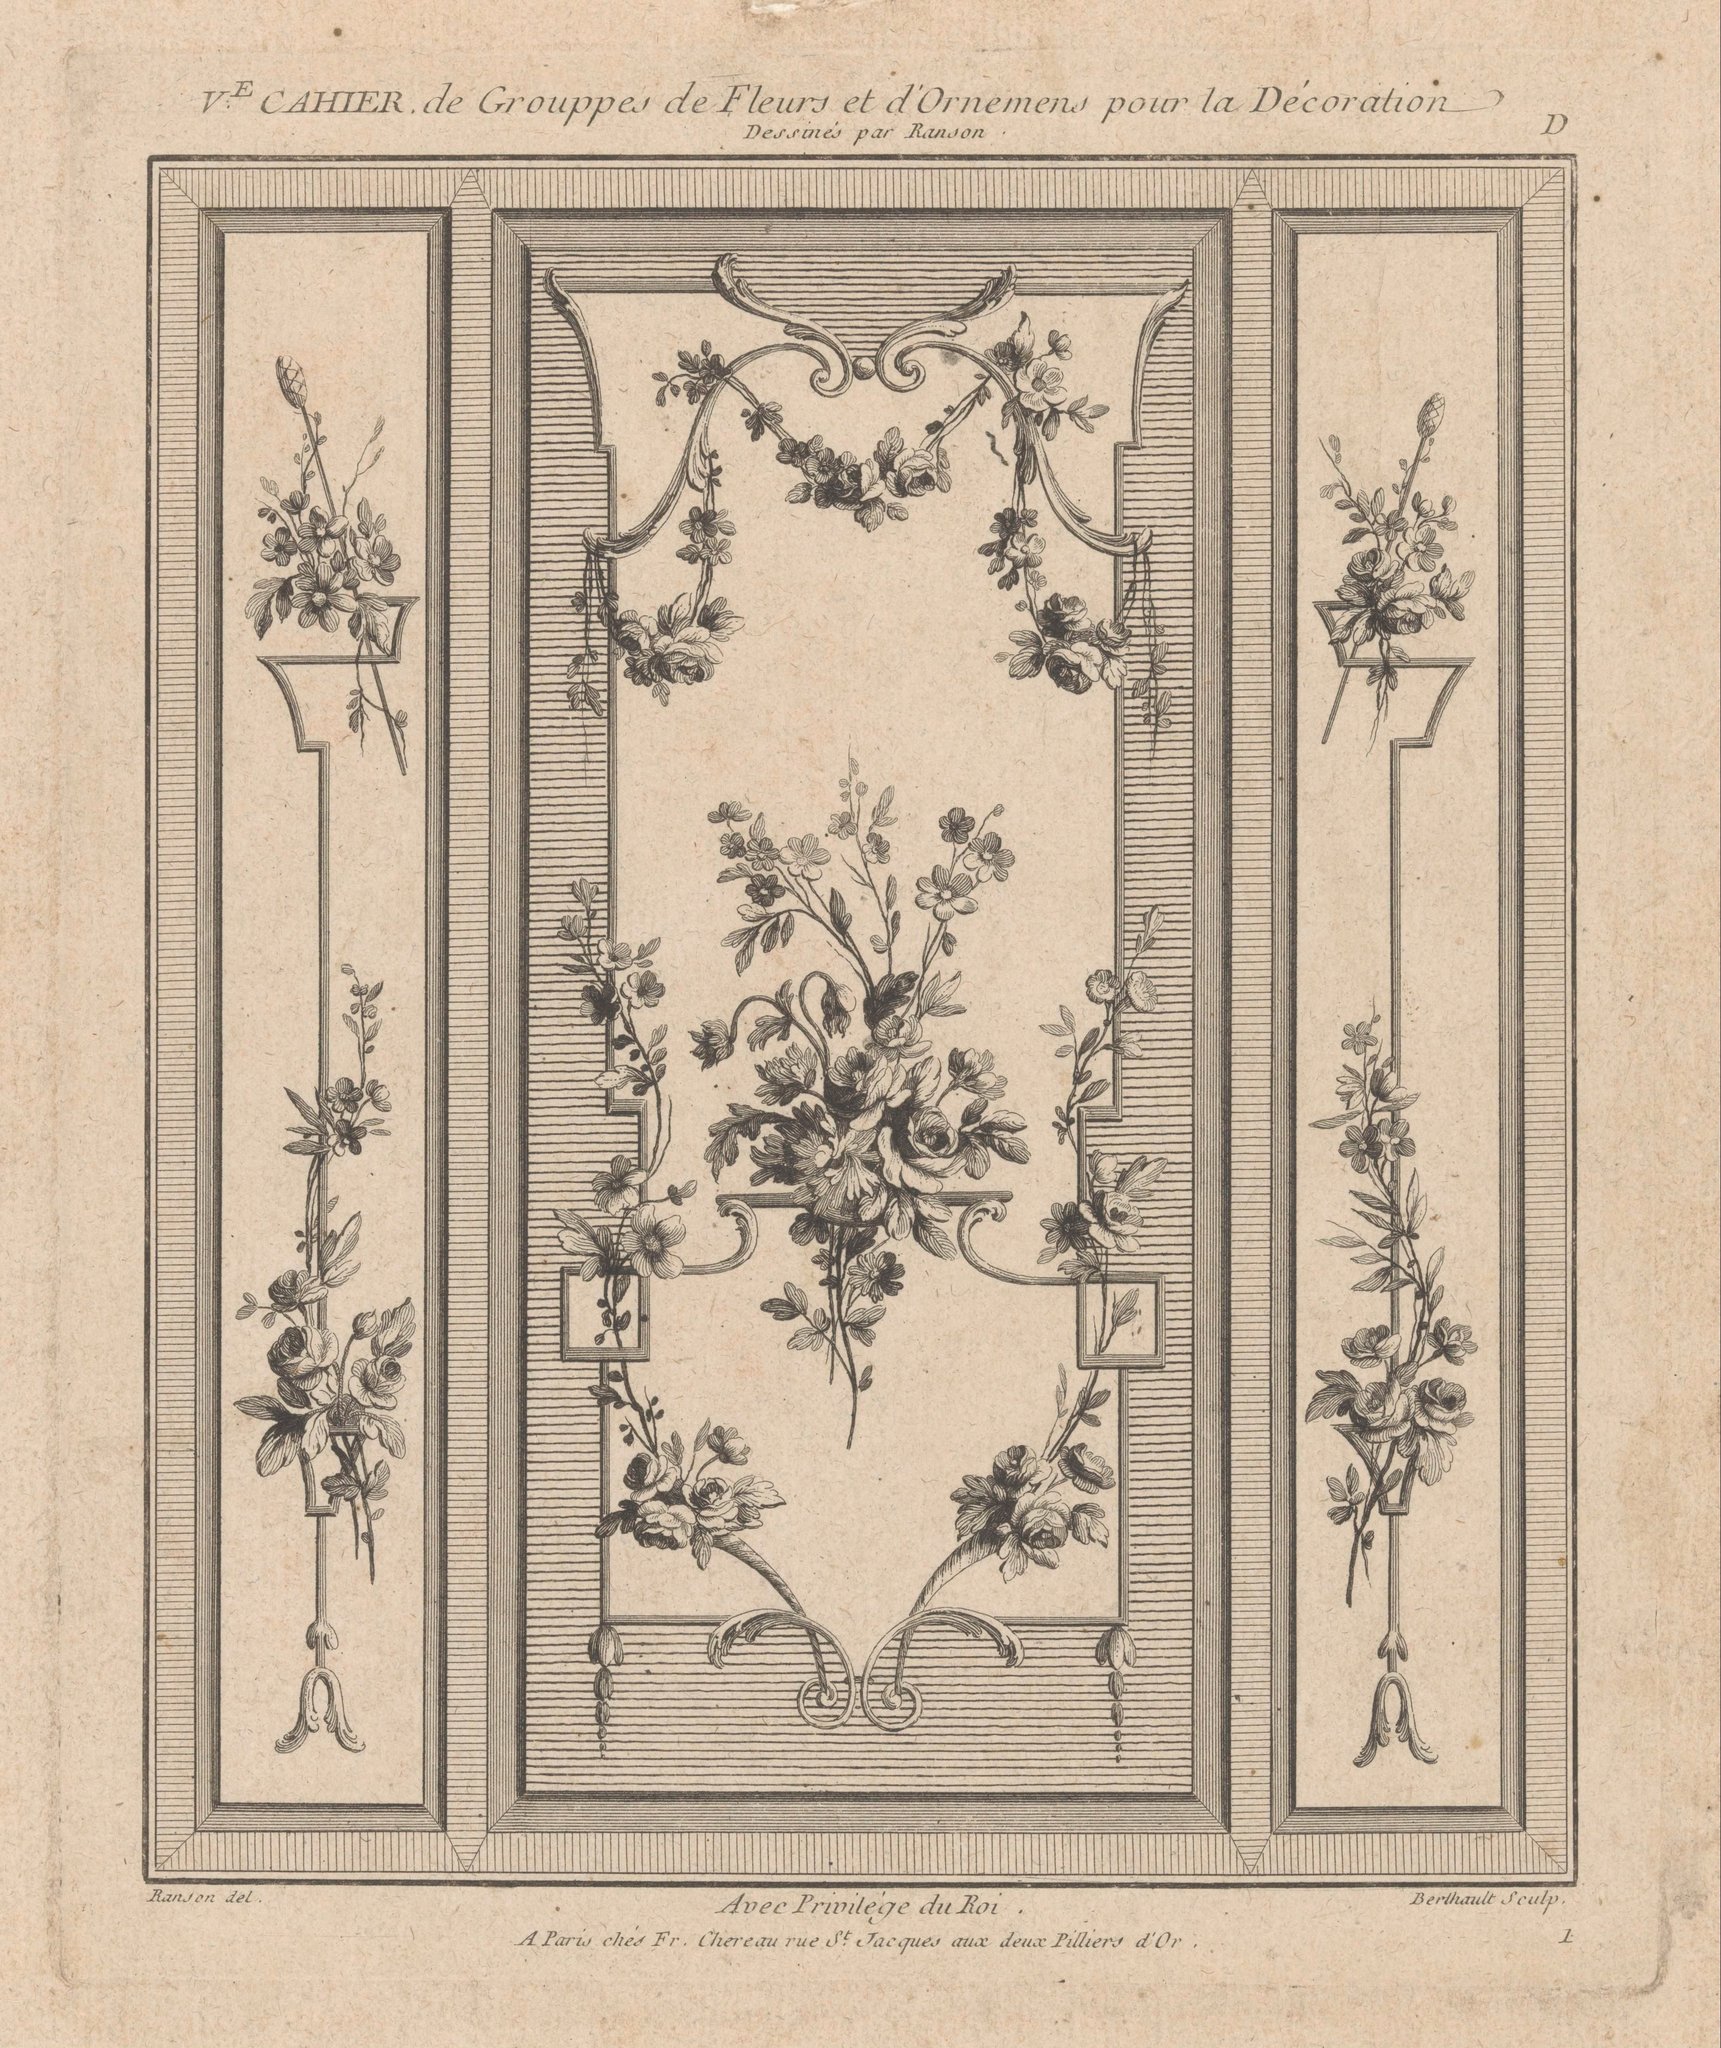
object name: print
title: Drie panelen met bloemen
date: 1768-1786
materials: paper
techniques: etching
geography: paris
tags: flowers, panelling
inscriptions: collector's mark: Lugt 2228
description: Drie langwerpige panelen met vlechtwerk en bloemen.